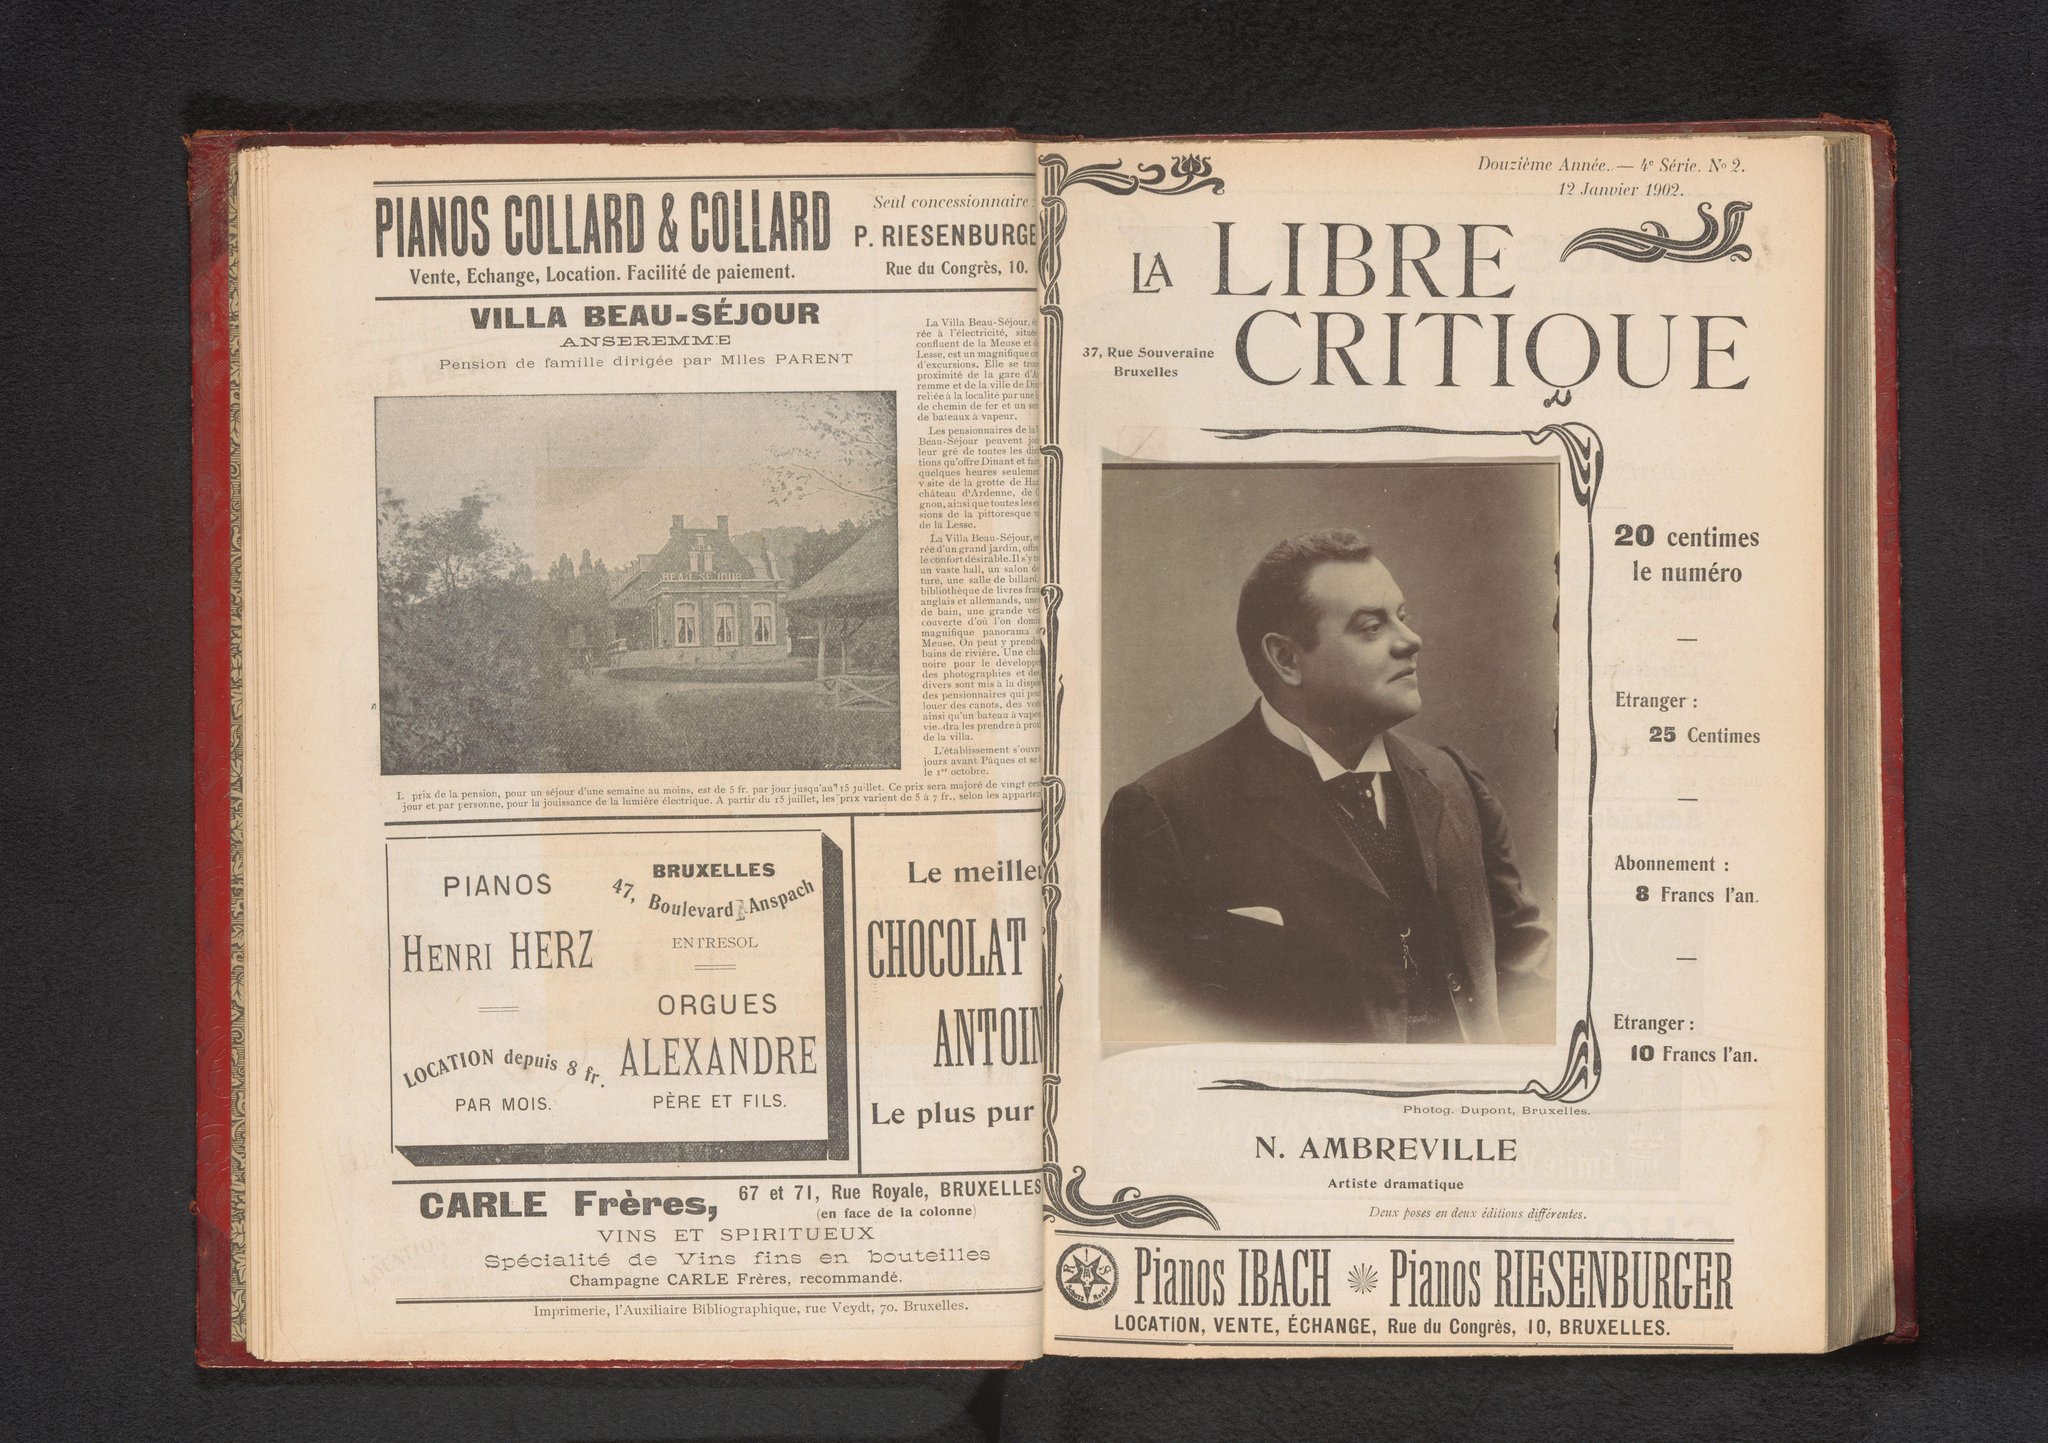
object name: photomechanical print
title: N. Ambreville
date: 1897-1902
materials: paper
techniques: photograph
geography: brussels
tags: brussels, portrait of actor, actress